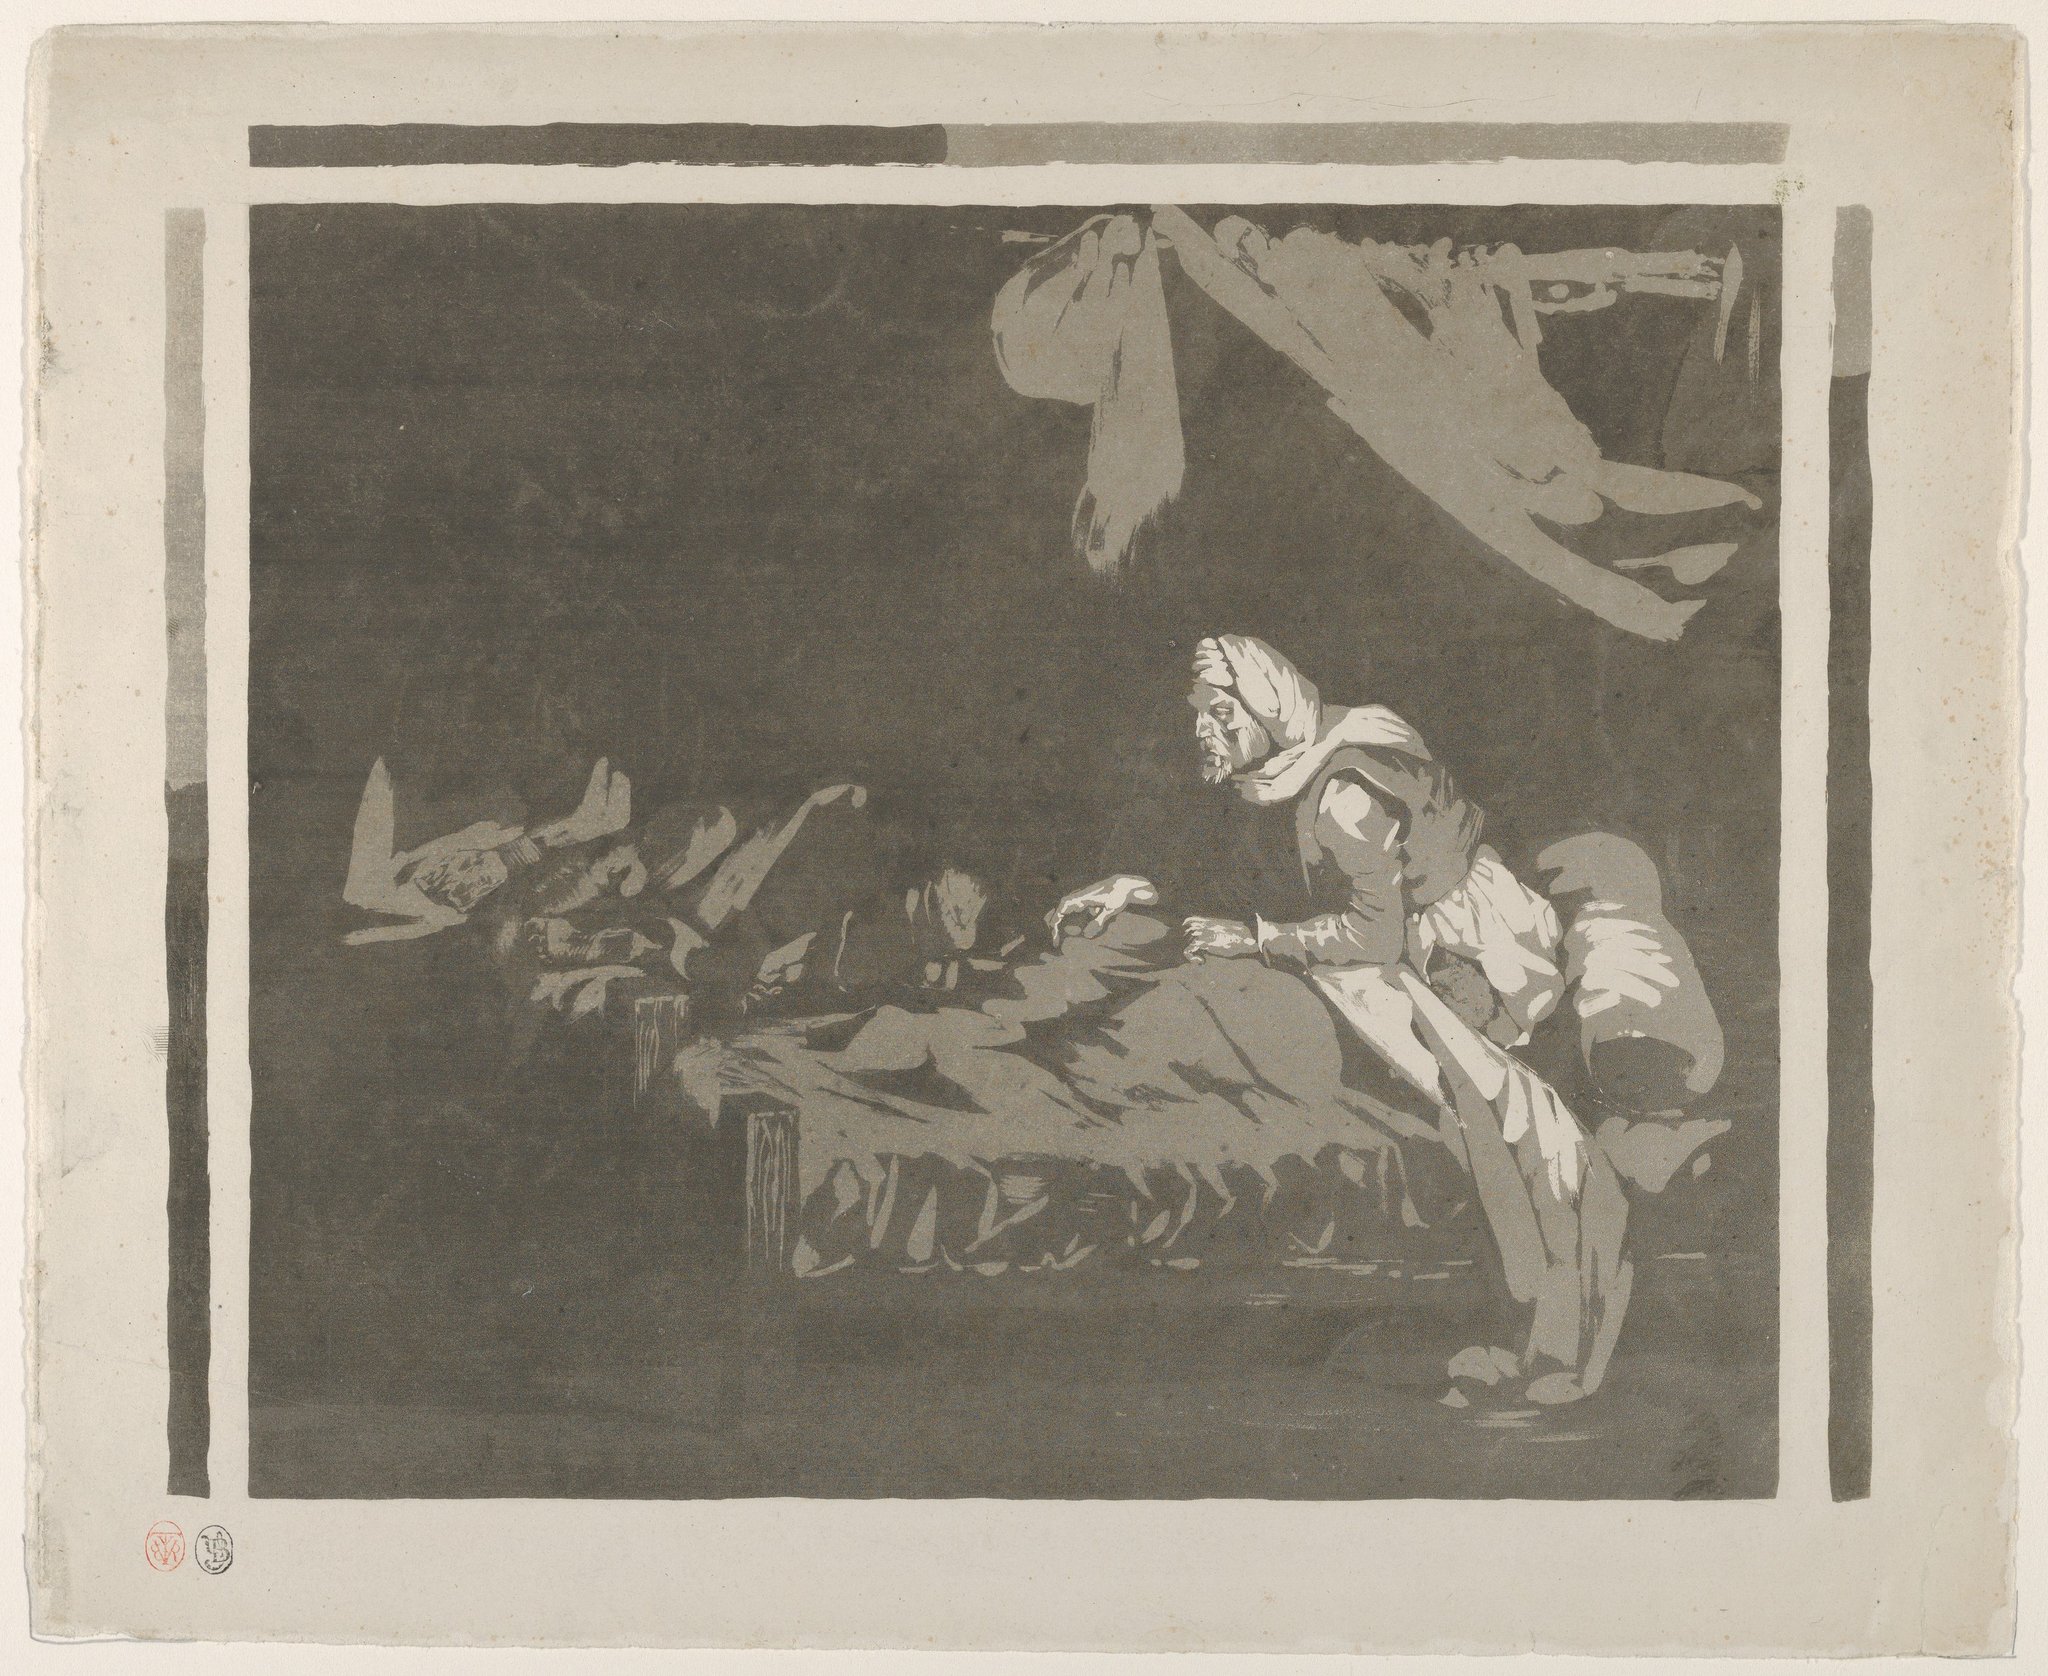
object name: print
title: Interior of a Military Hospital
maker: eugène delacroix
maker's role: artist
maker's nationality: french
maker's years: 1798-1863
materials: ink, paper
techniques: aquatint, printing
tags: human figures,hospitals